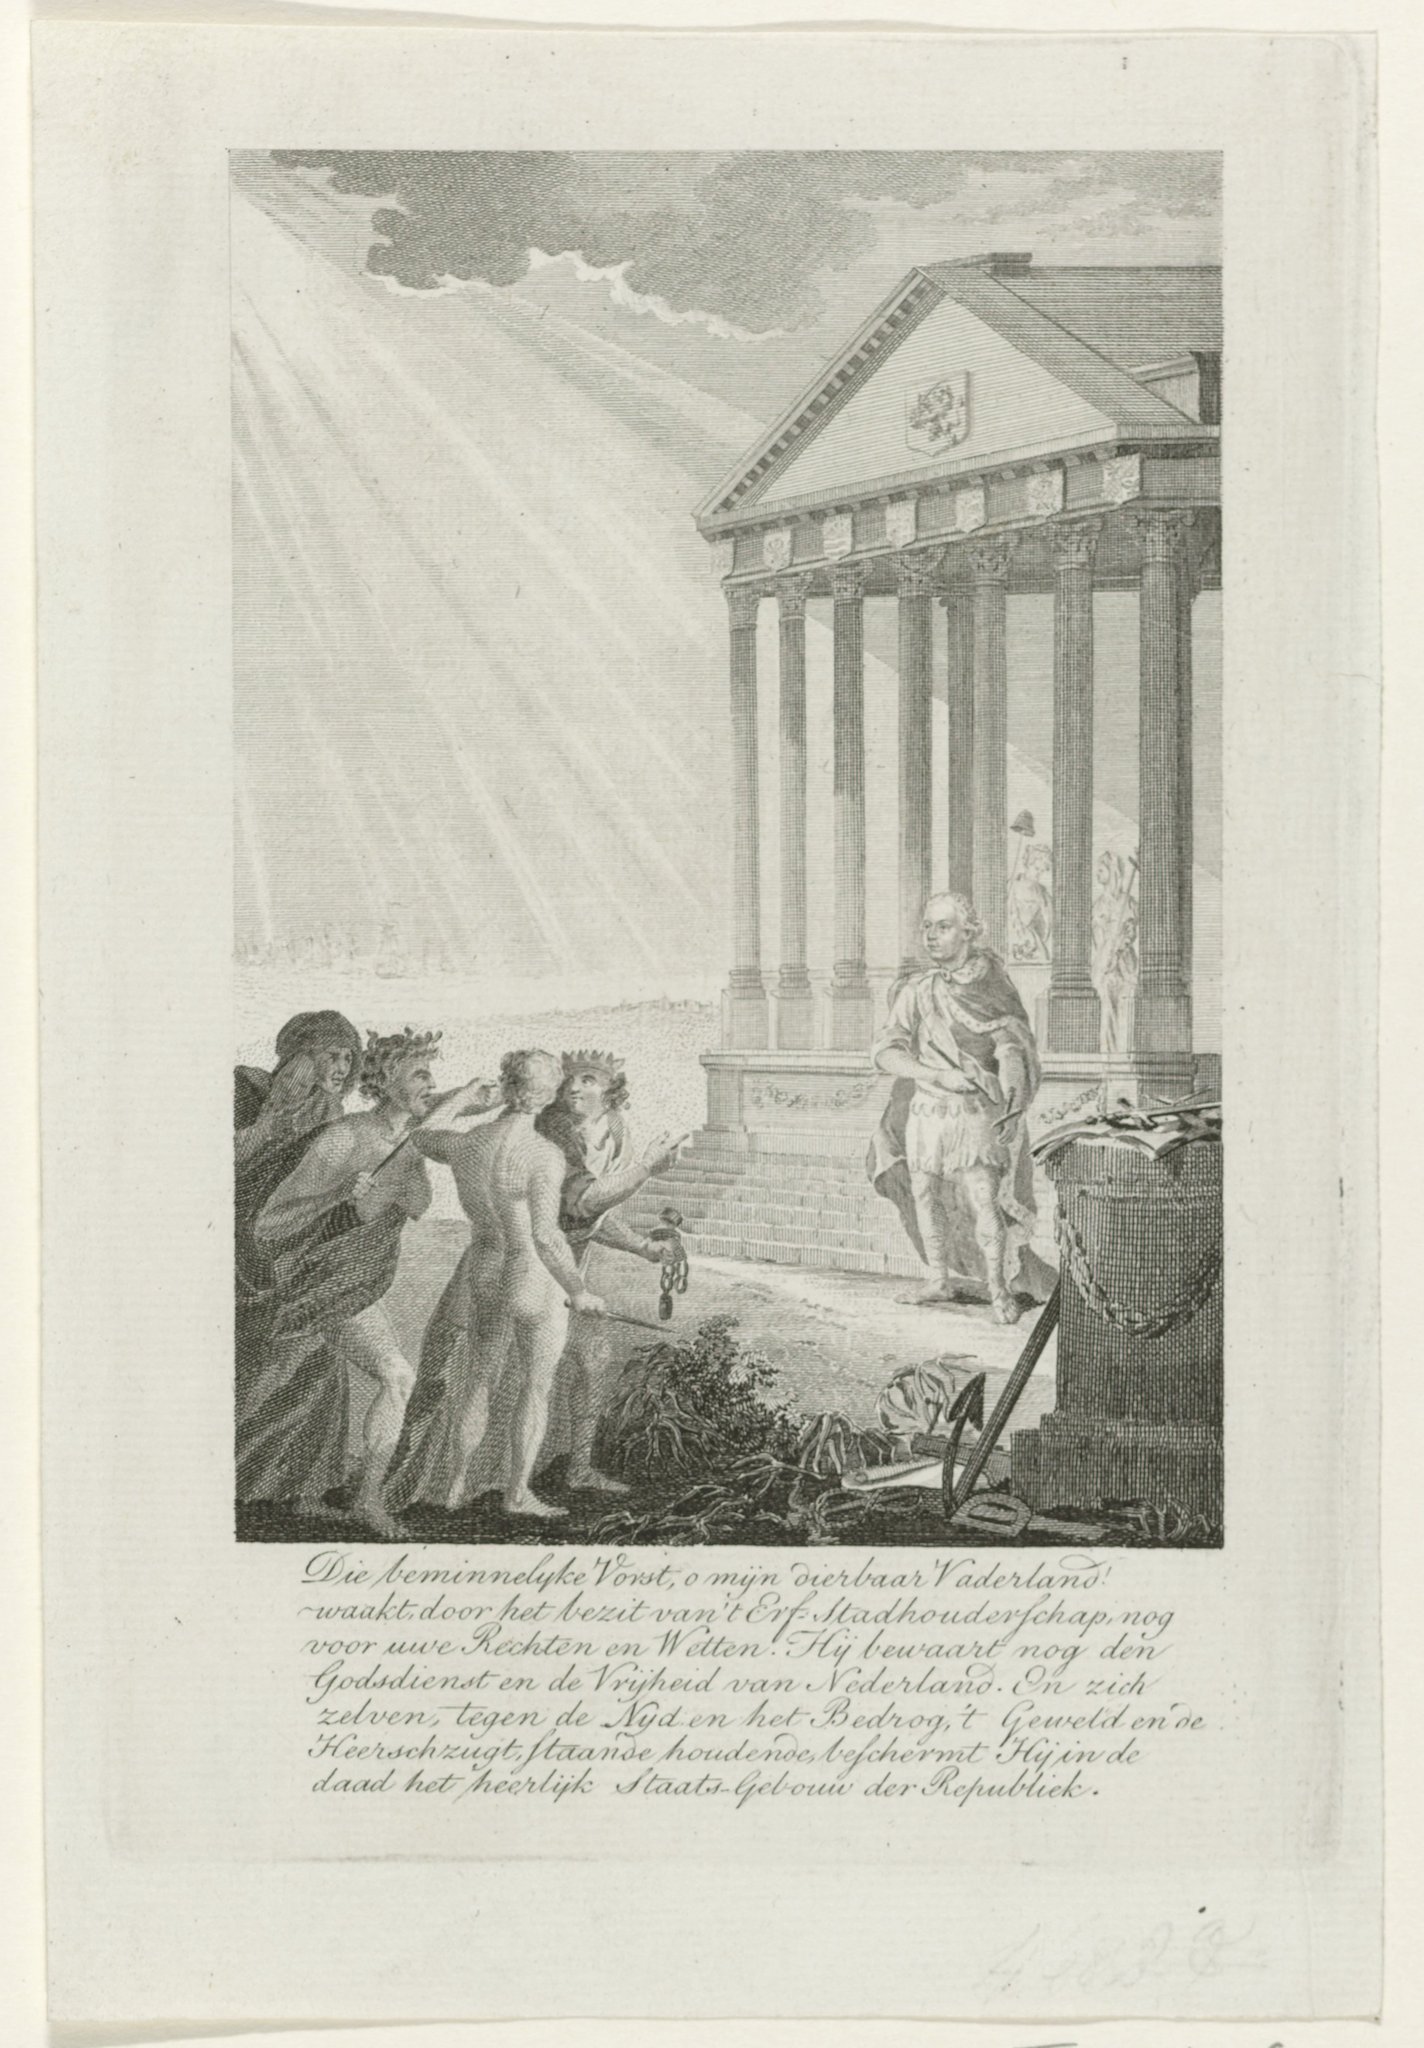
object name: titelblad, titelpagina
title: Titelpagina voor: Kornelis de Vogel, Katechismus van het stadhouderschap, 1786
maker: Anonymous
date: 1785-1786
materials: paper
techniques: engraving, etching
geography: rotterdam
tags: the hague, william v (prince of orange), patriots (1780-1795)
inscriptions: collector's mark: Lugt 2228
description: Titelpagina voor het oranjegezinde werk: Katechismus van het stadhouderschap, 1786. Voor een tempel met zeven pilaren in het stralende zonnelicht staat prins Willem V. Als beschermer van het Staatsgebouw van het Nederlandse Gemenebest verdedigt het erfstadhouderschap in de persoon van de stadhouder het land tegen de aanvallen van Nijd, Bedrog, Geweld en Heerszucht. In de tempel verblijven de Vrijheid en de Godsdienst. In het onderschrift een vers van zeven regels. Bij de prent behoort een bericht van de uitgever met een verklaring van de plaat.